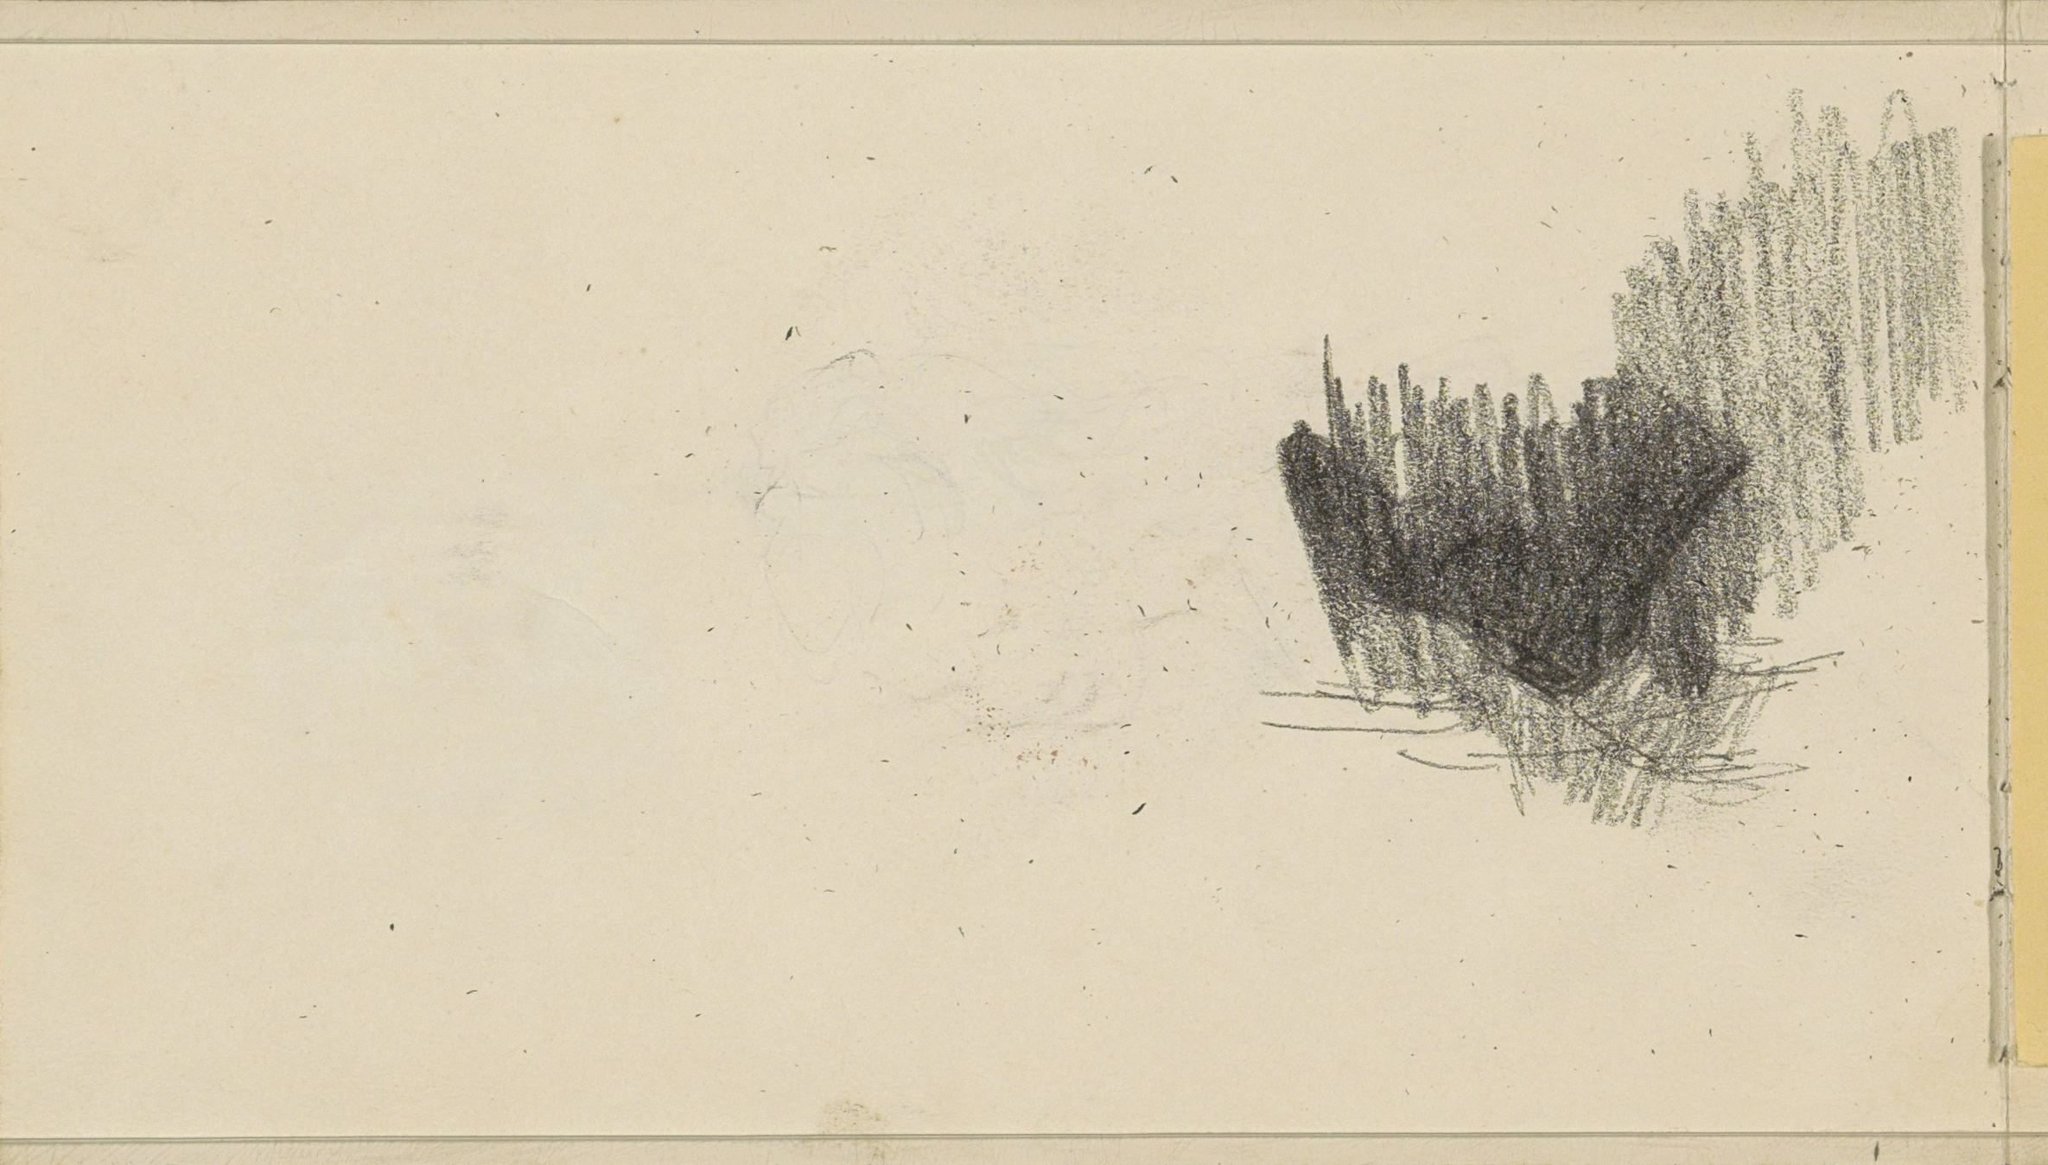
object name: sketchbook leaf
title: Studie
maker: julie de graag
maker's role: draughtsman, print maker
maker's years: 1877-1924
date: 1892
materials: paper, pencil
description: Blad 1 verso uit een schetsboek met 22 bladen.